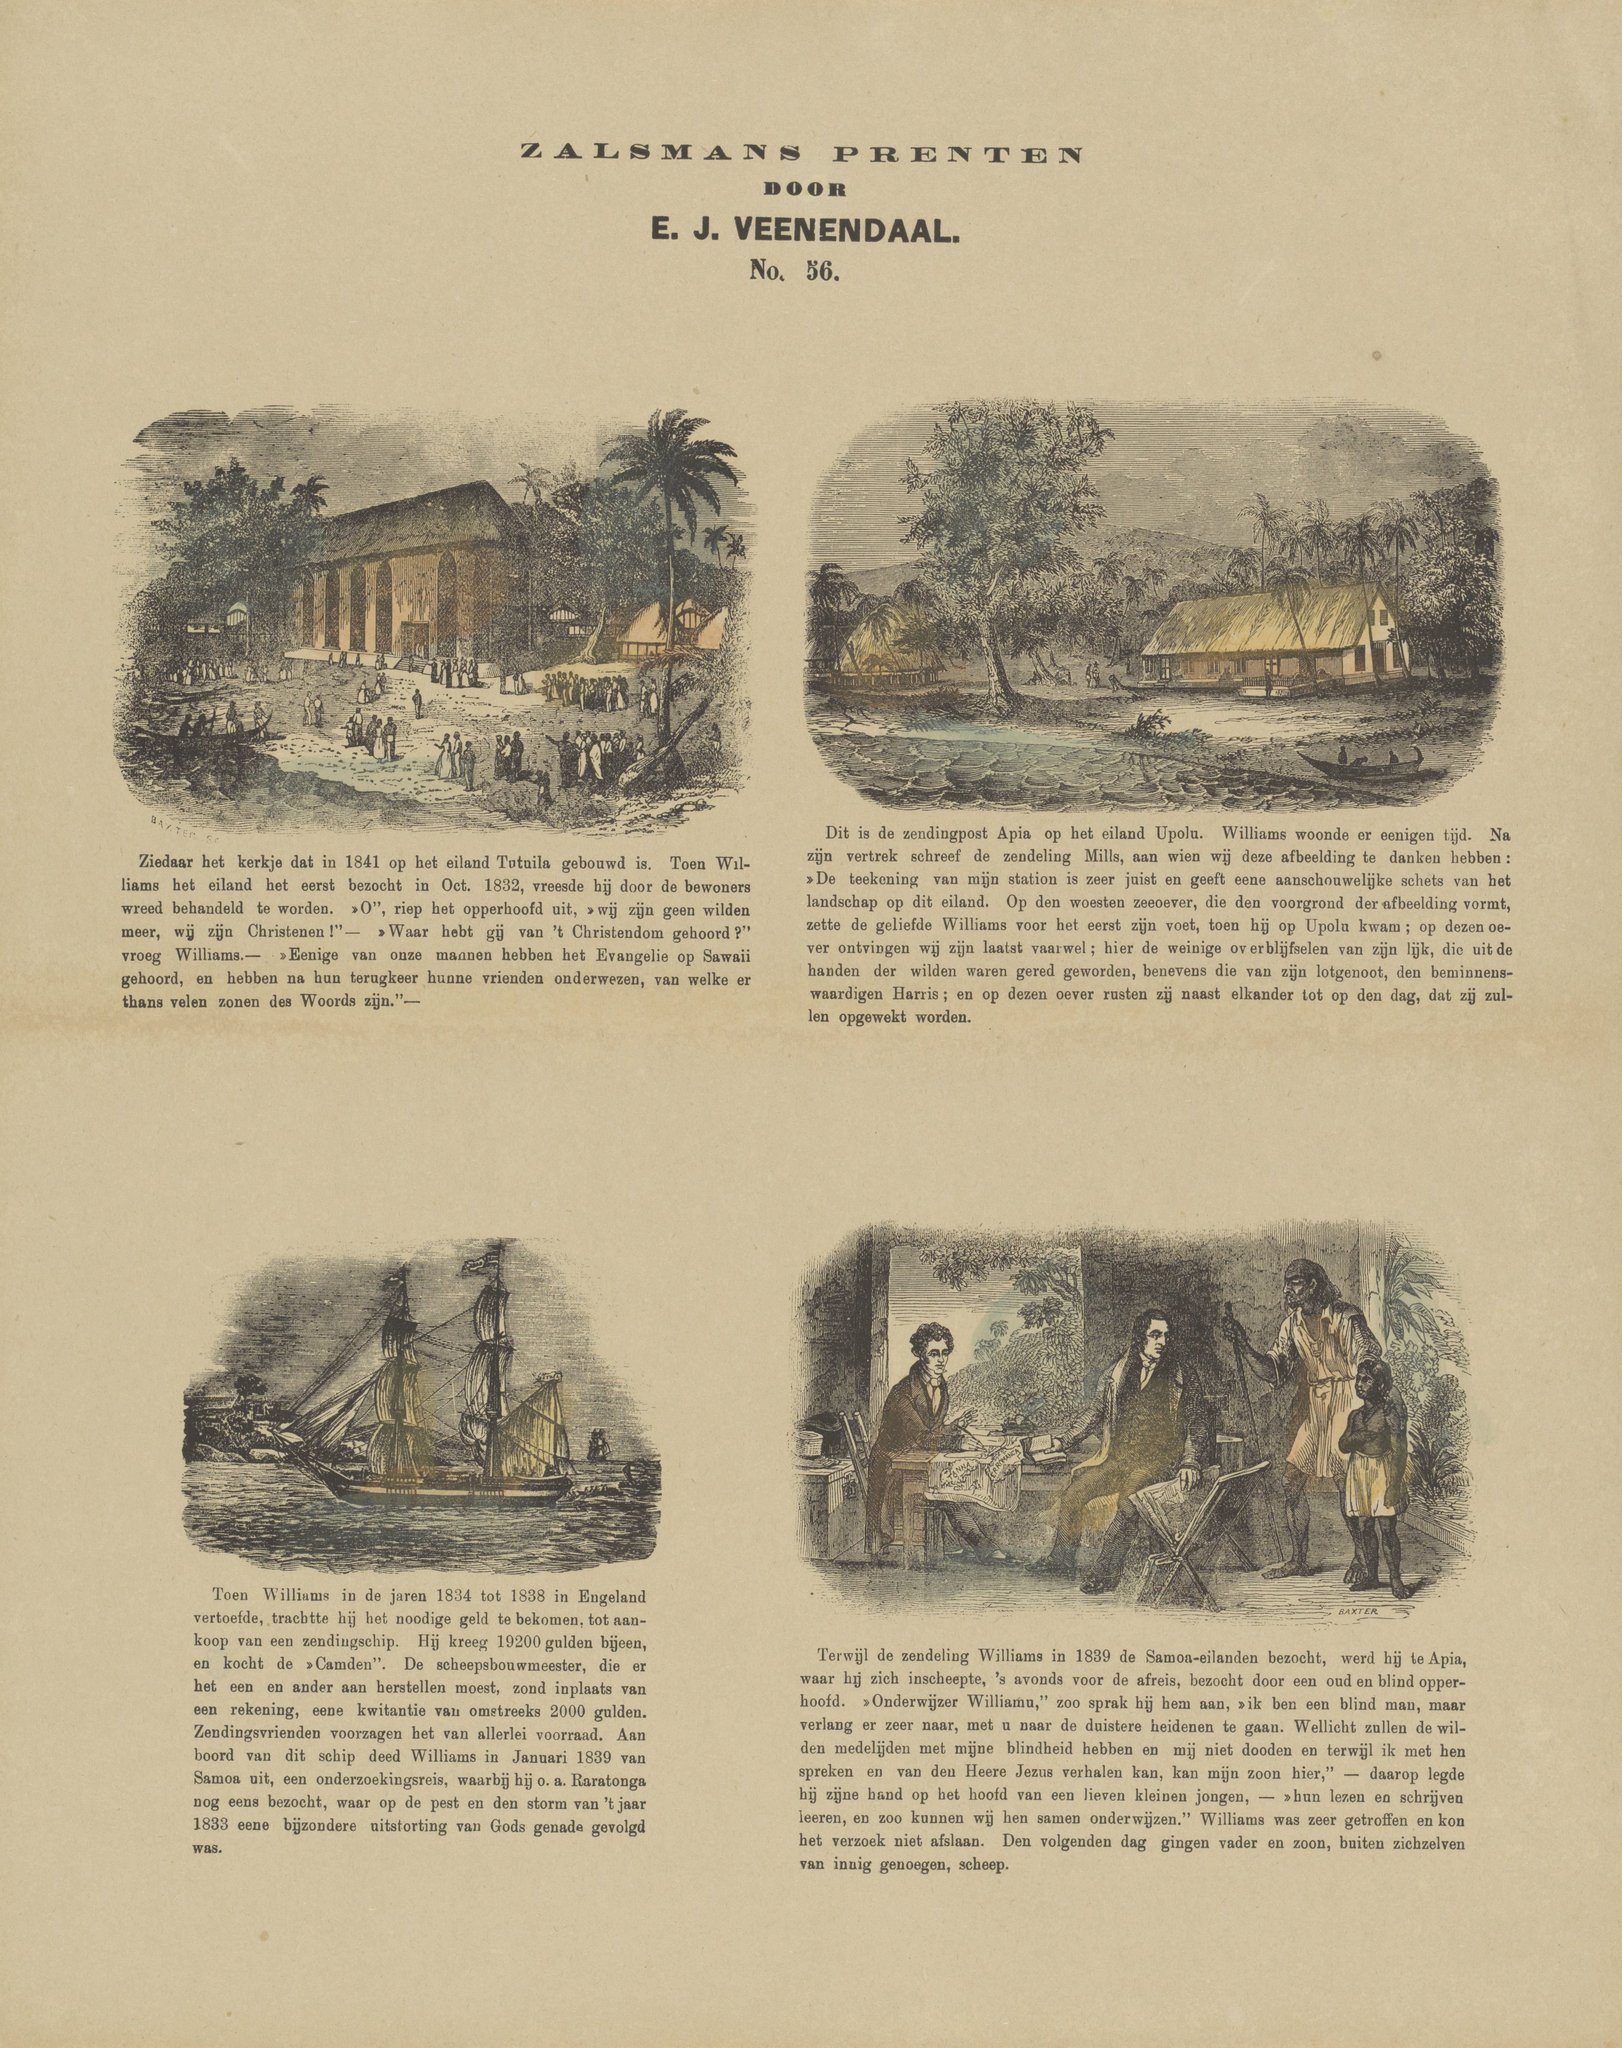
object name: popular print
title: John Williams op Samoa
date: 1869-1882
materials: paper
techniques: colour, letterpress printing, engraving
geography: netherlands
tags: missionary, ships (in general), spreading the gospel; missionary work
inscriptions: collector's mark: Lugt 2760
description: Blad met 4 voorstellingen van de missionaris John Williams op Samoa. Onder elke afbeelding een onderschrift. Genummerd midden boven: No. 56.